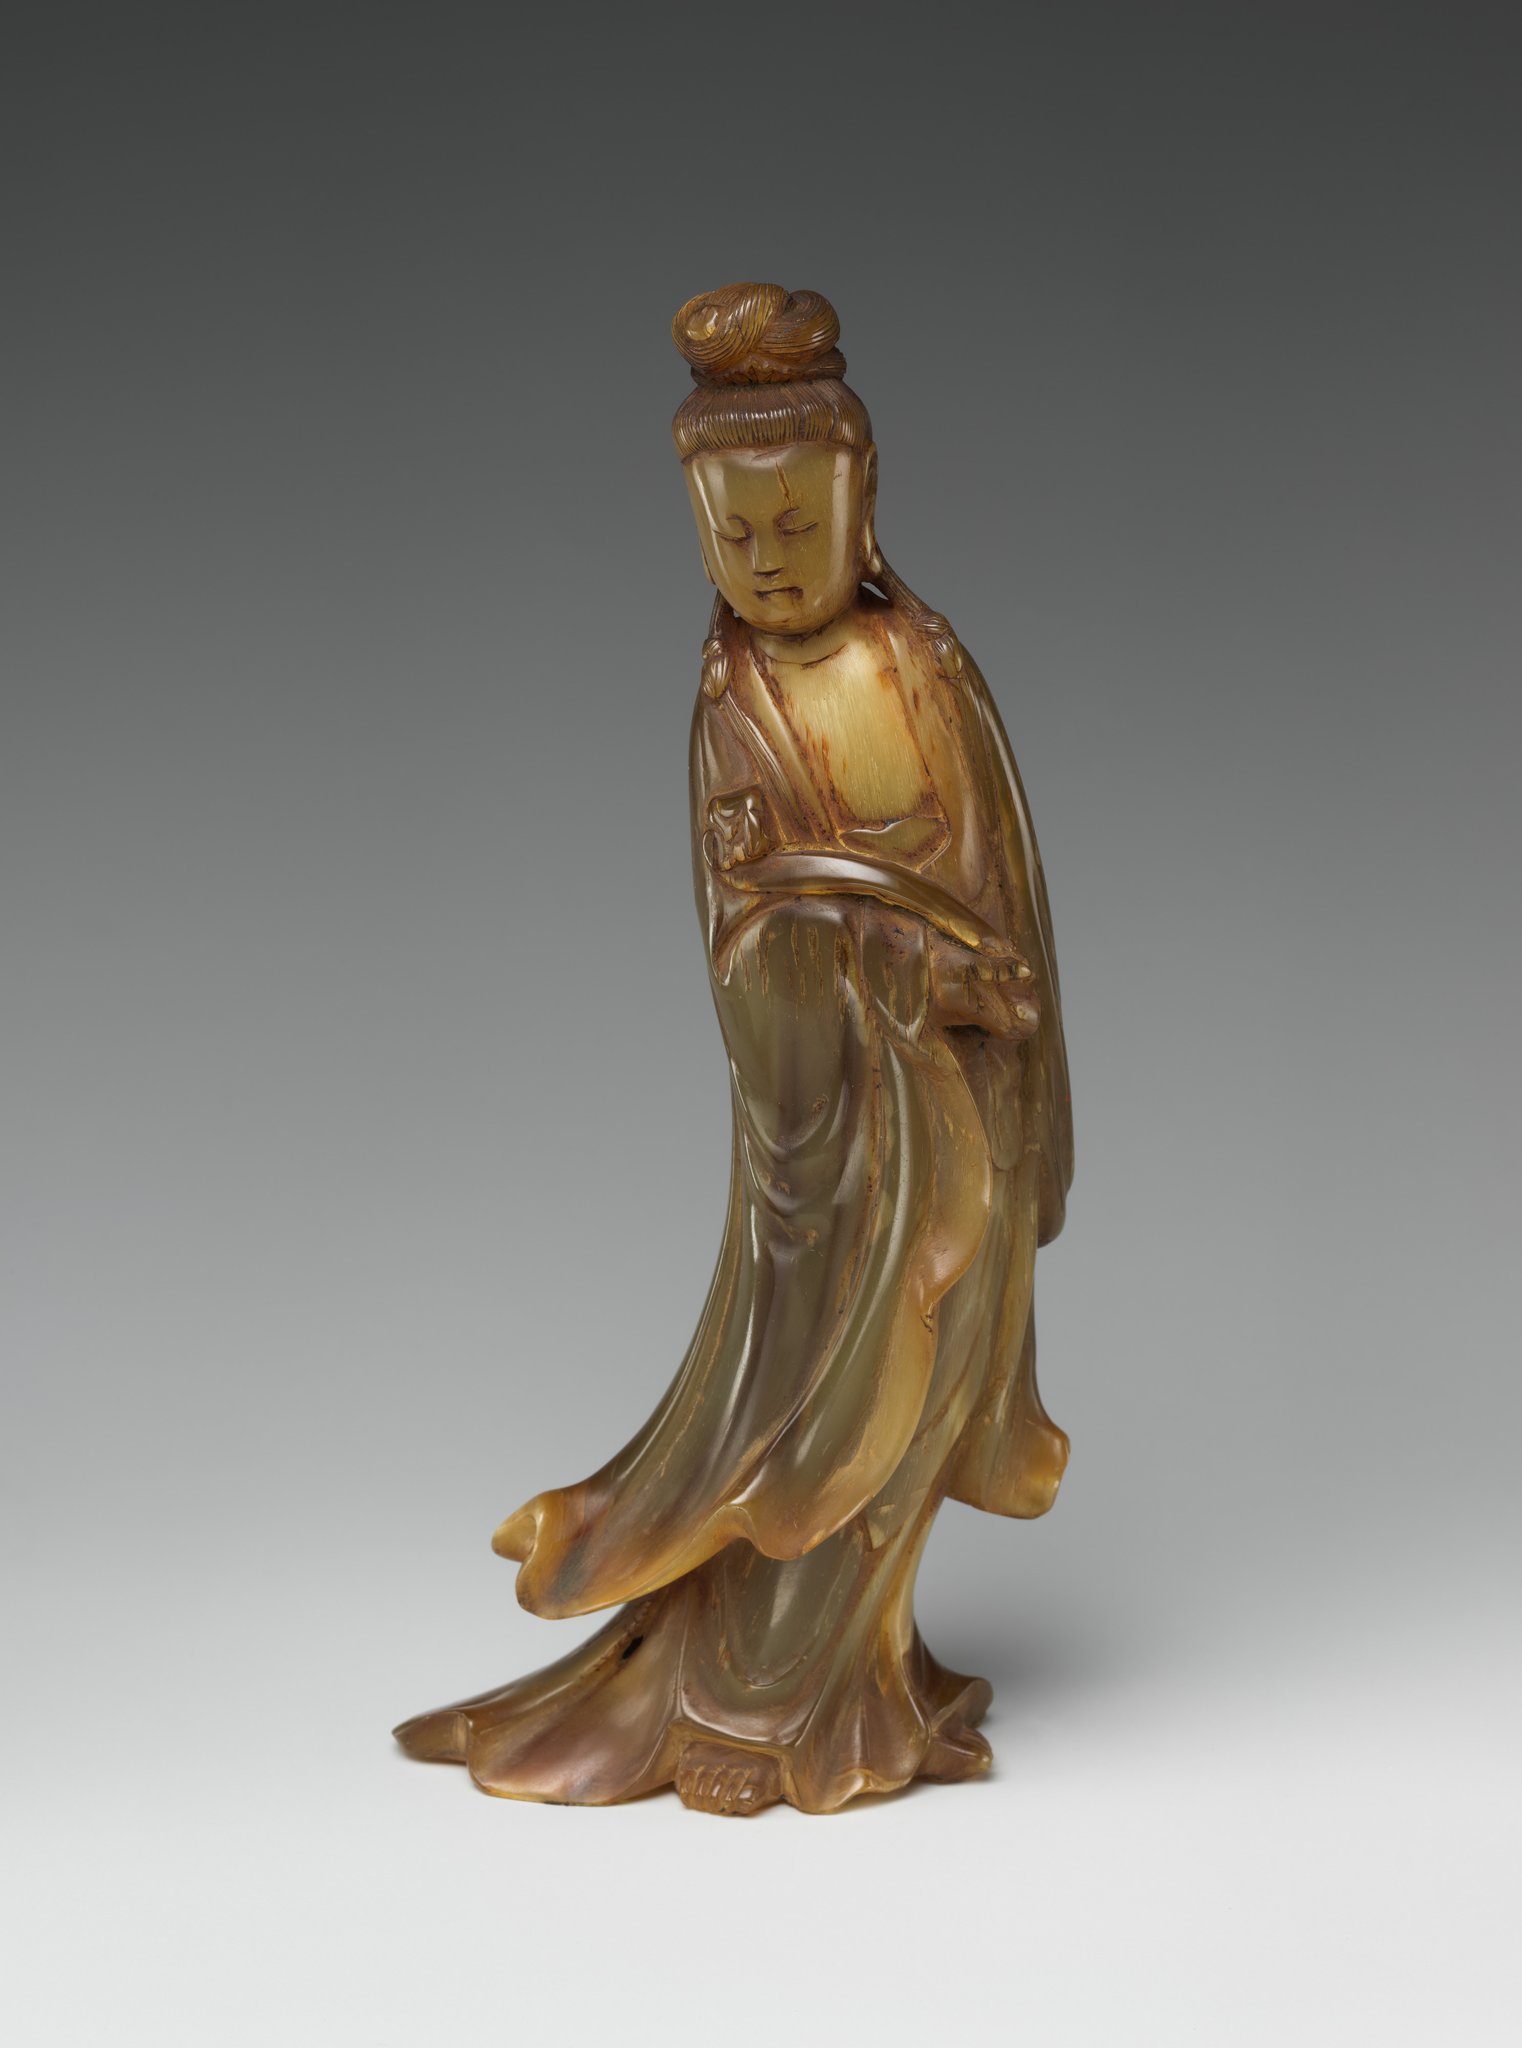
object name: figure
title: Bodhisattva Guanyin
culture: chinese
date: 1701-1900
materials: horn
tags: buddhism,bodhisattvas